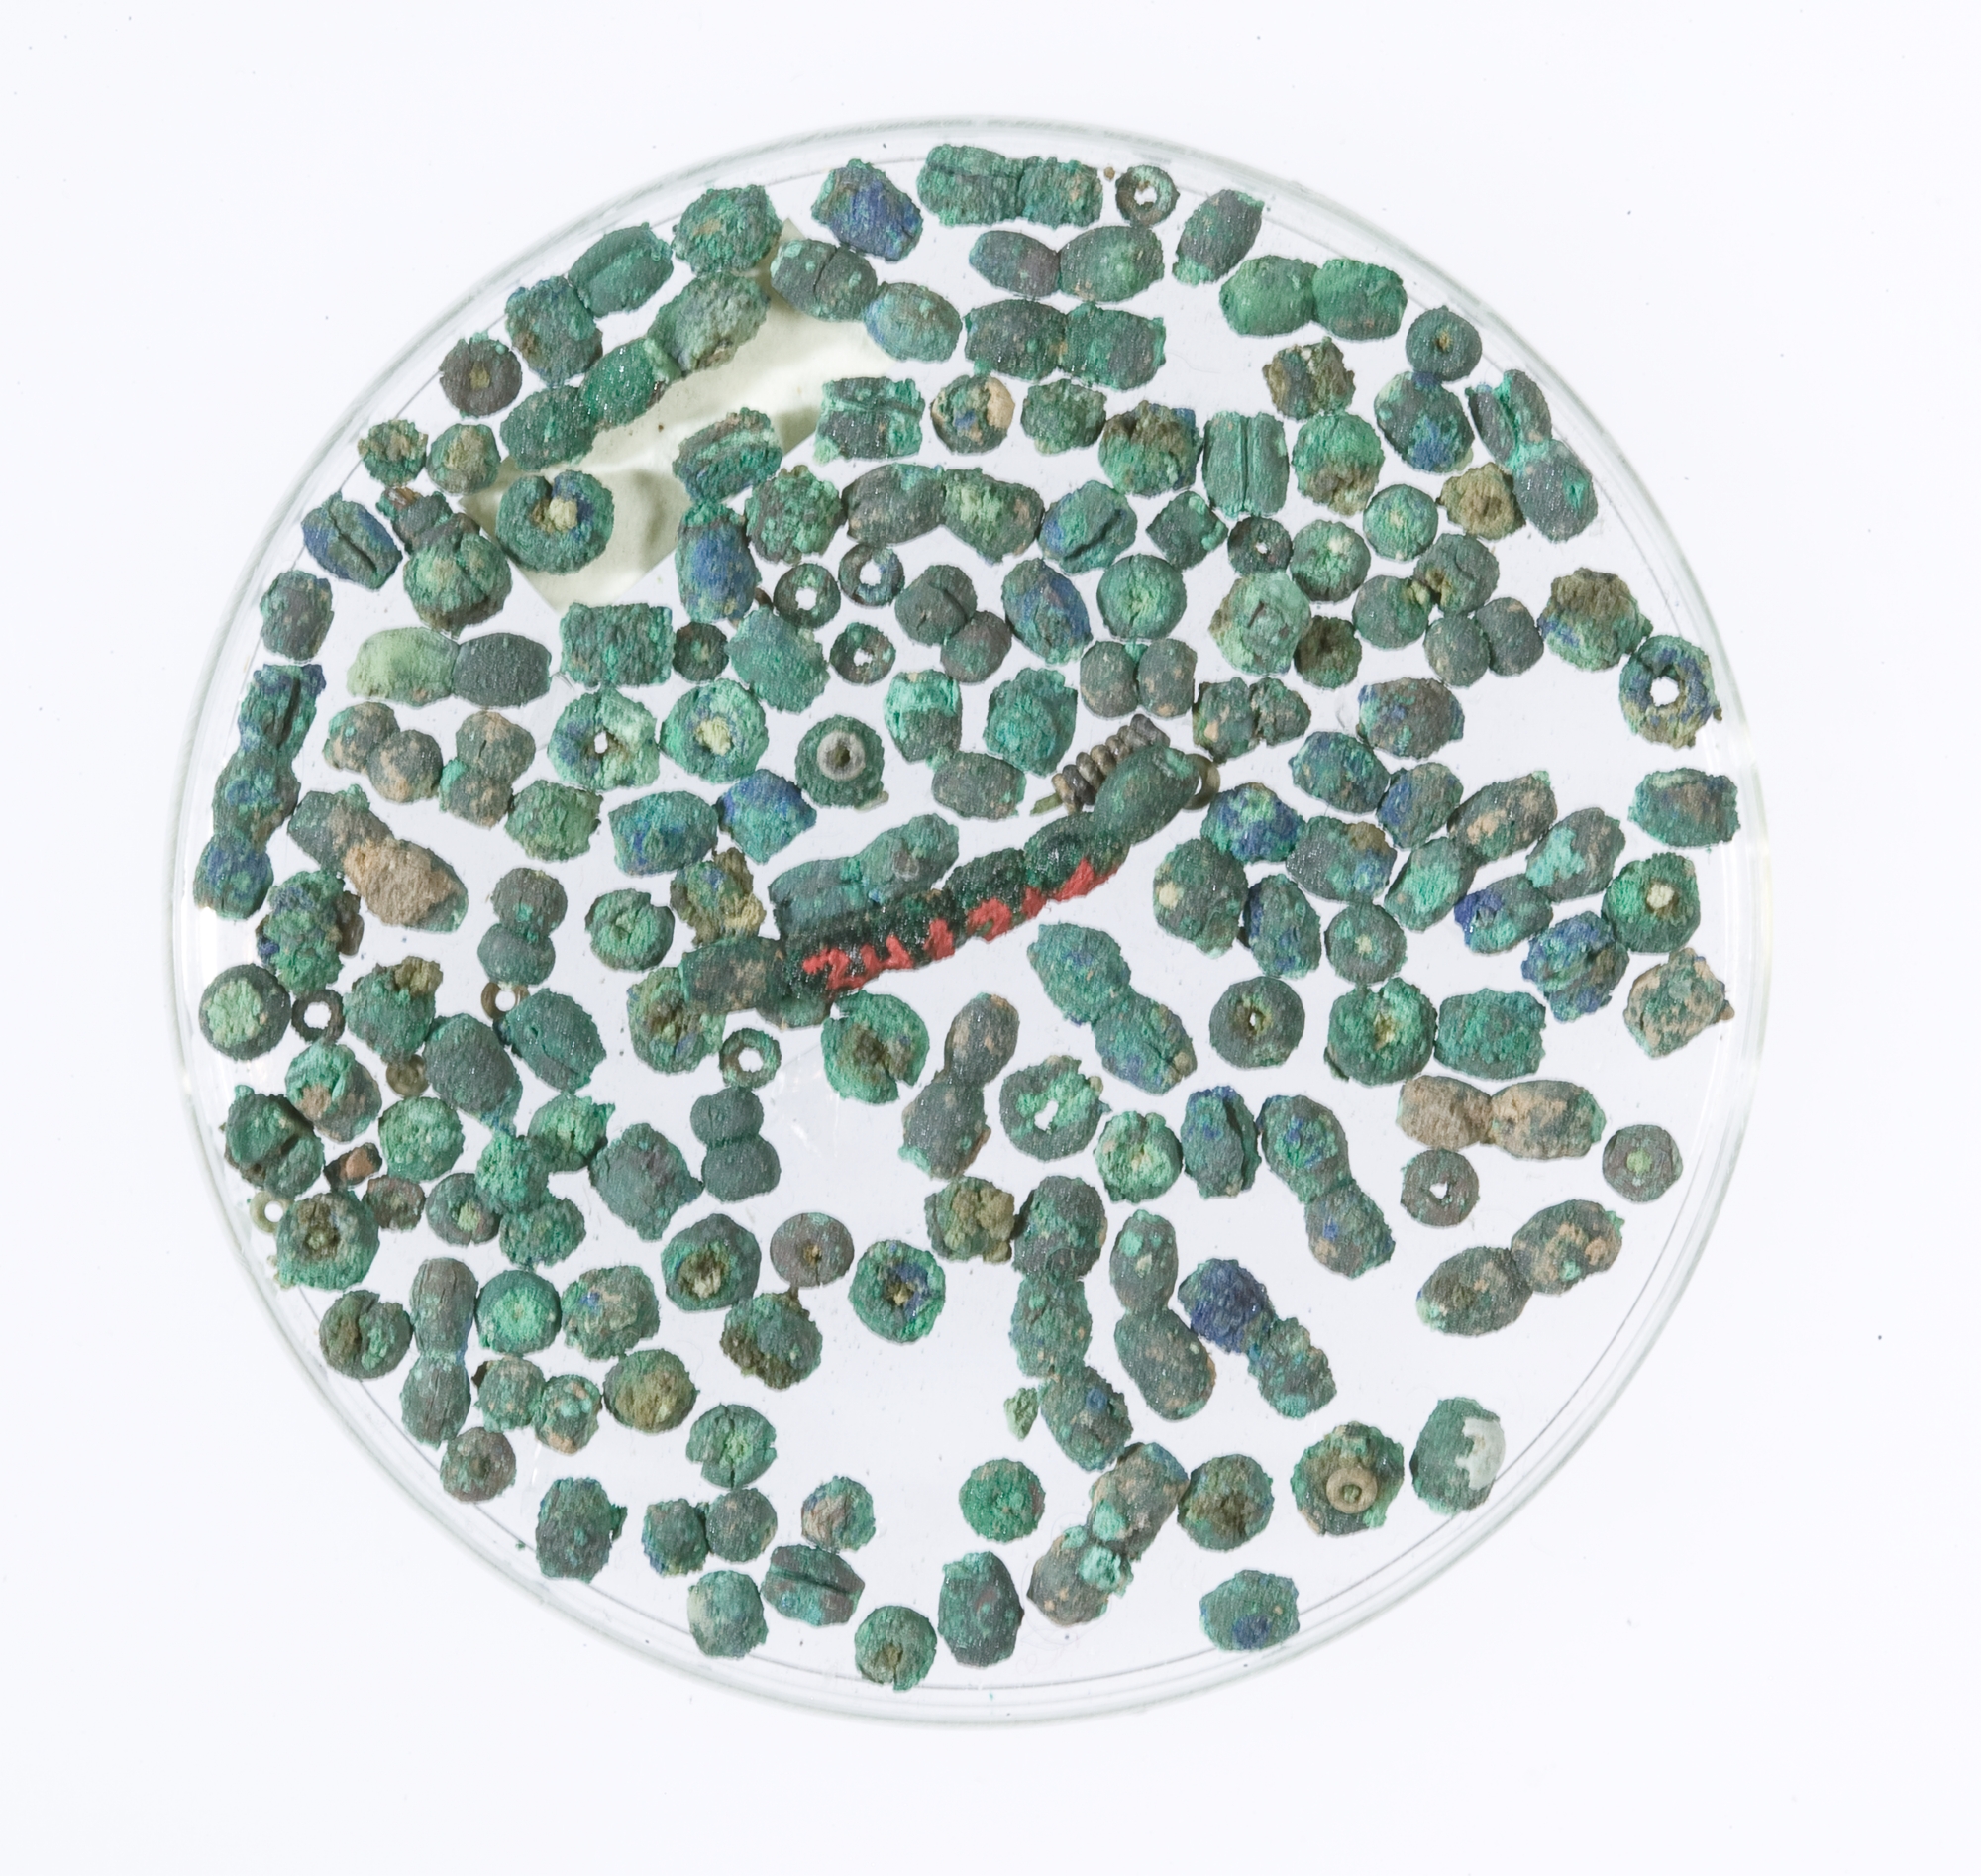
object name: bead dish, hepy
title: Beads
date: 1981-1640 BCE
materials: bronze, copper alloy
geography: egypt